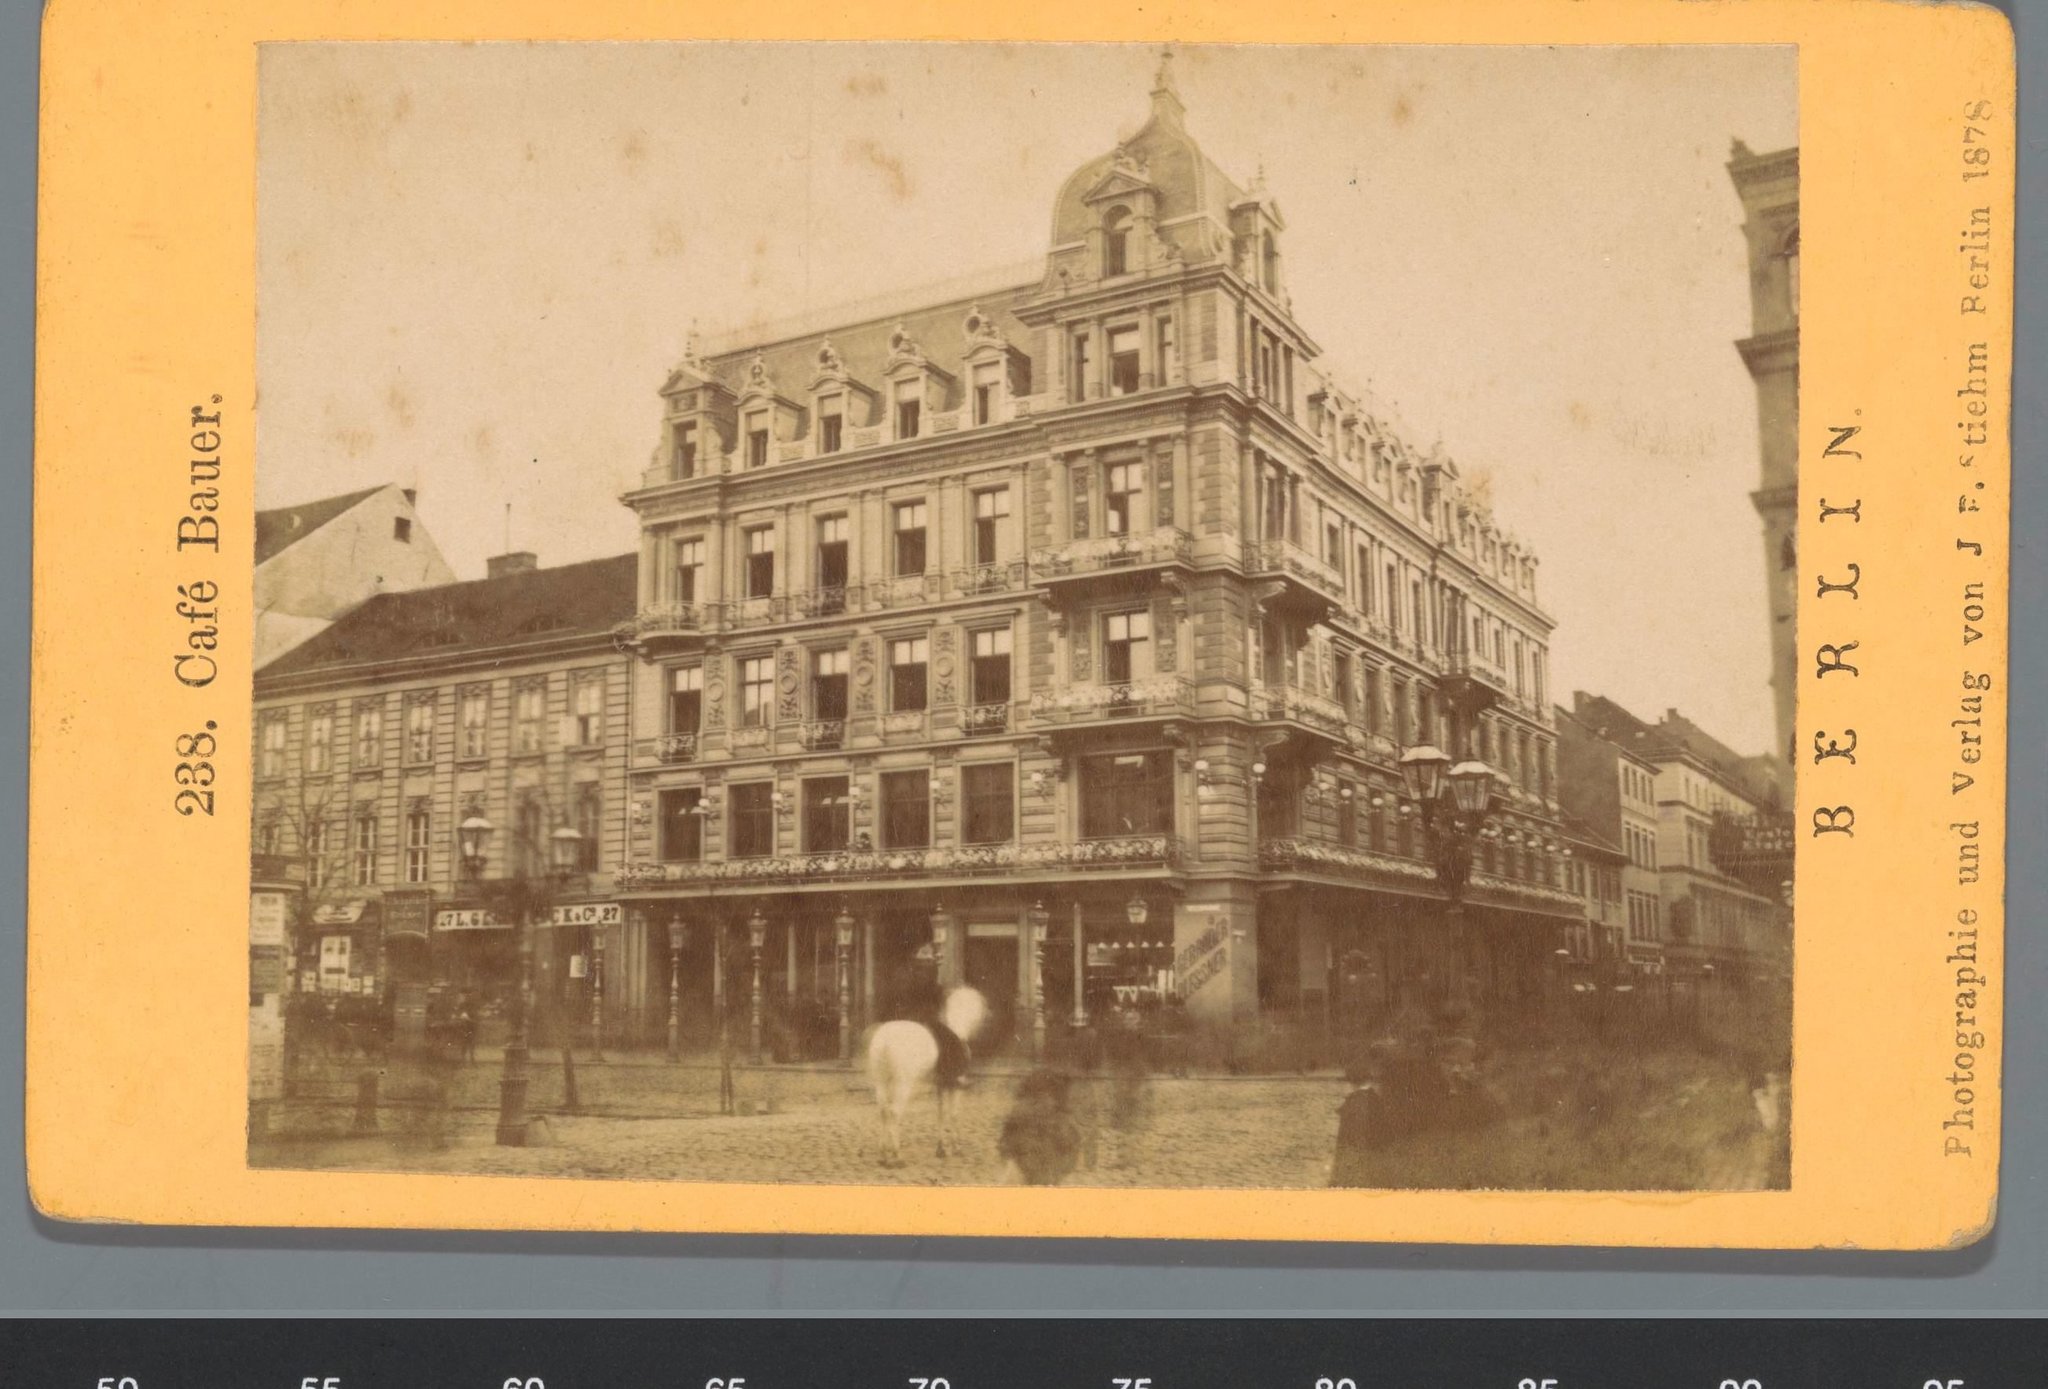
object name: carte de visite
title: Café Bauer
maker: johann friedrich stiehm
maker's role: fotograaf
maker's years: 1826-1902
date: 1878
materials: cardboard, paper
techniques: albumen print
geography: berlin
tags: inn, coffee-house, public house, etc.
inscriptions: number: ‘238.’